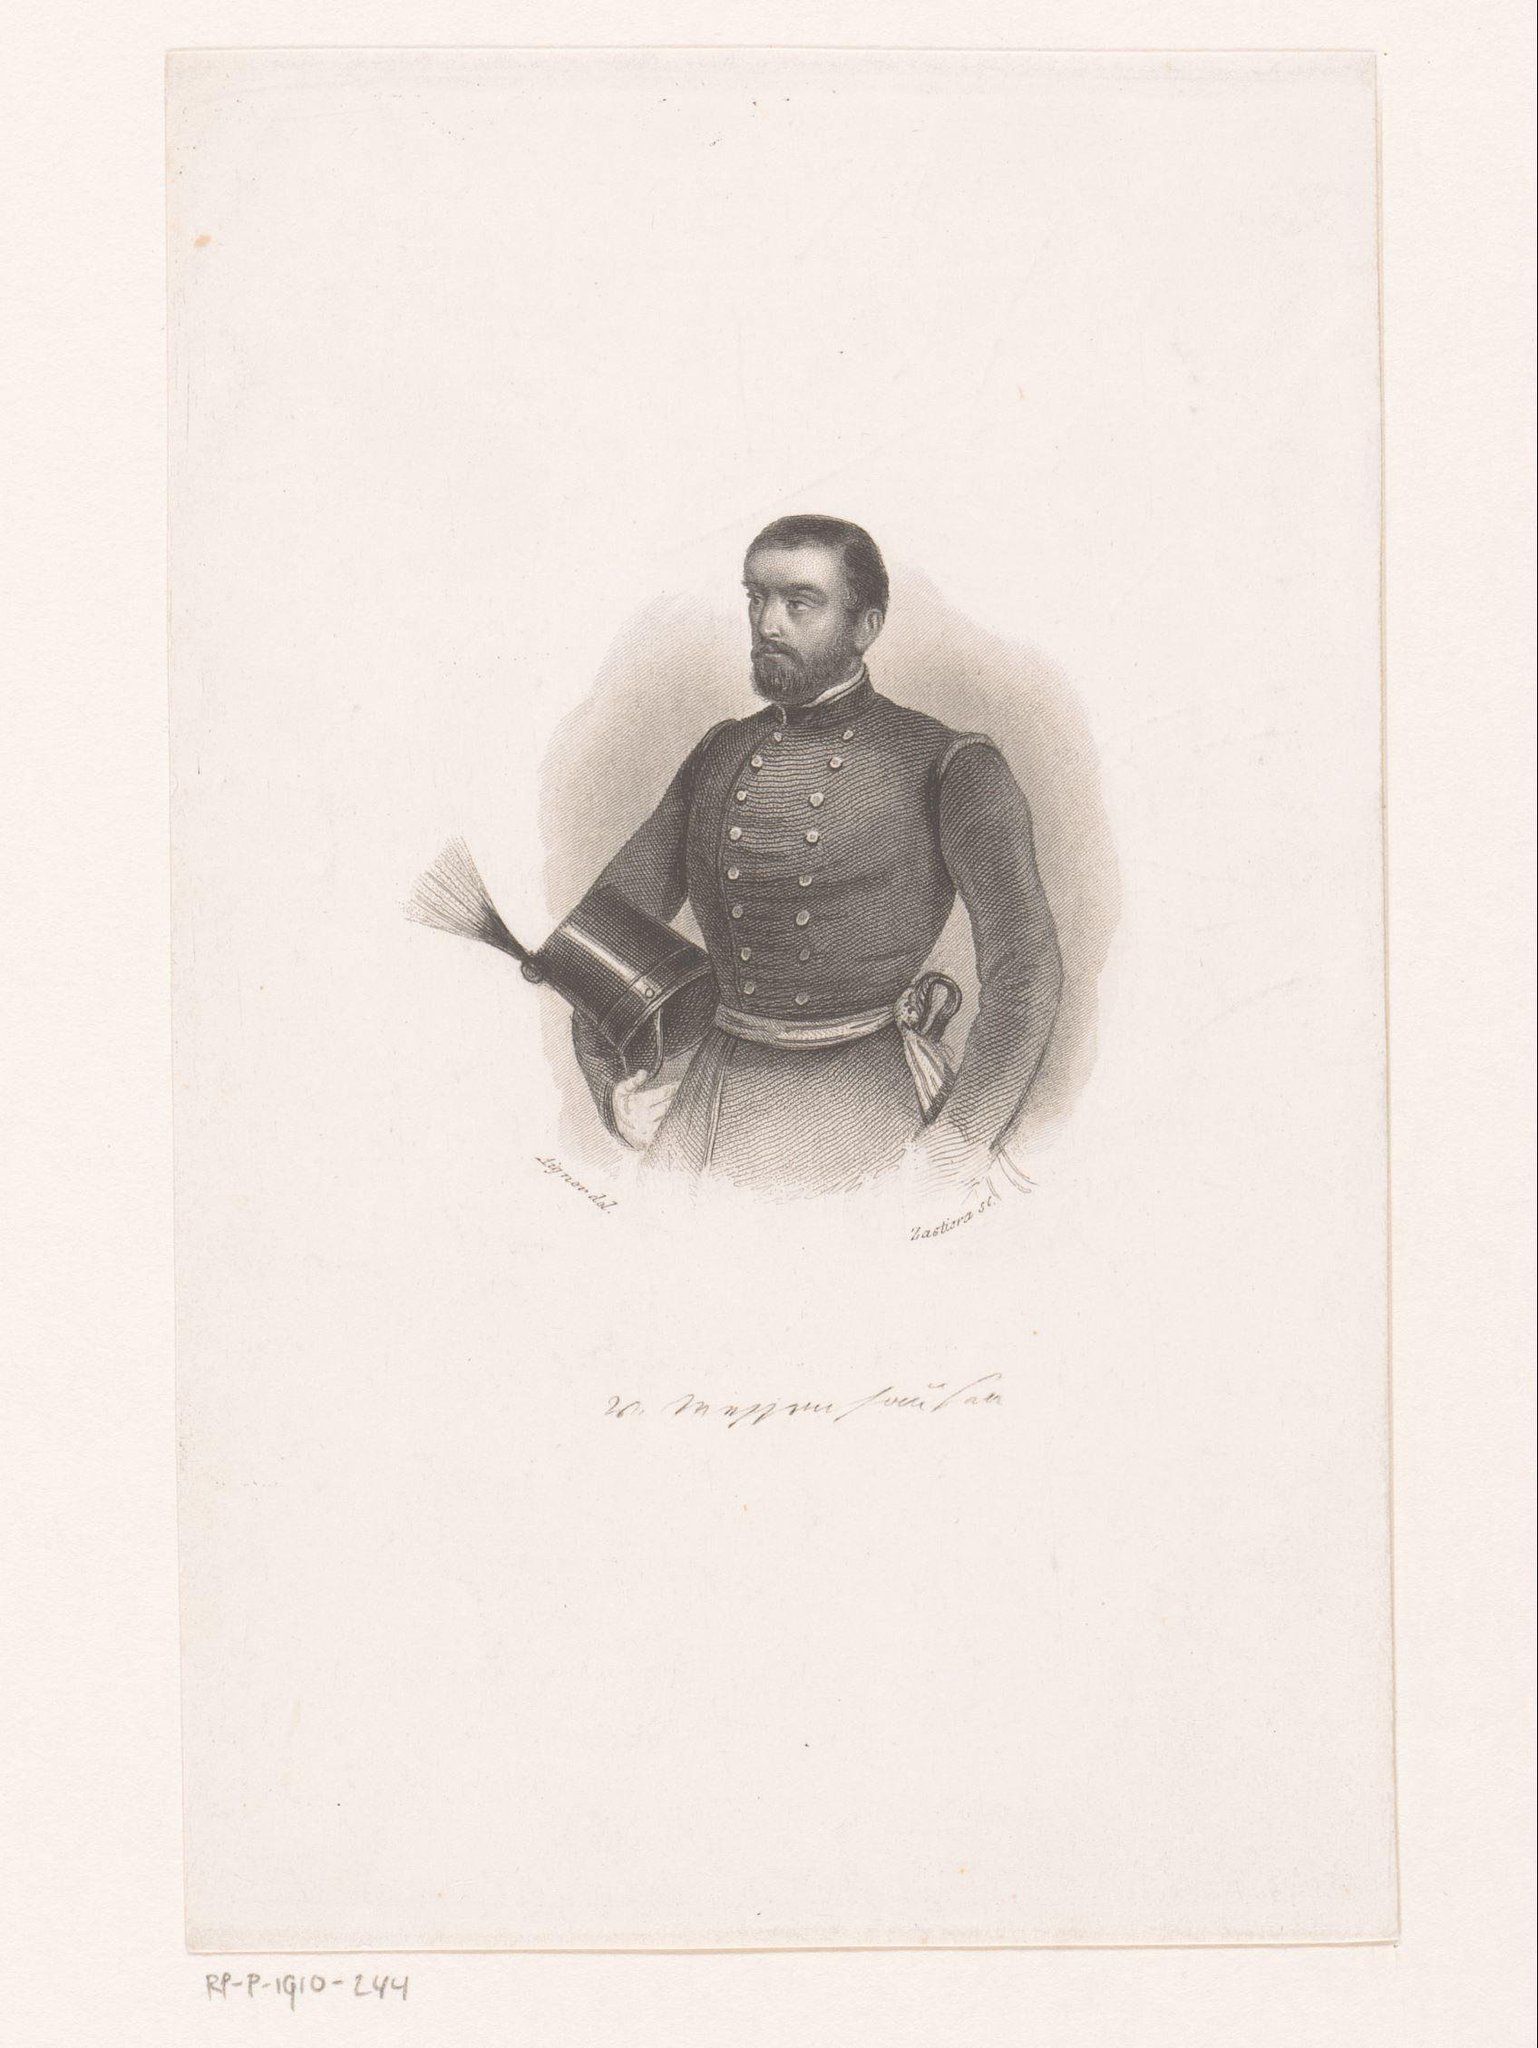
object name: print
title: Portret van Wenzel Messenhauser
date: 1845-1880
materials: paper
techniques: engraving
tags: vienna, historical persons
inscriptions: collector's mark: Lugt 2228